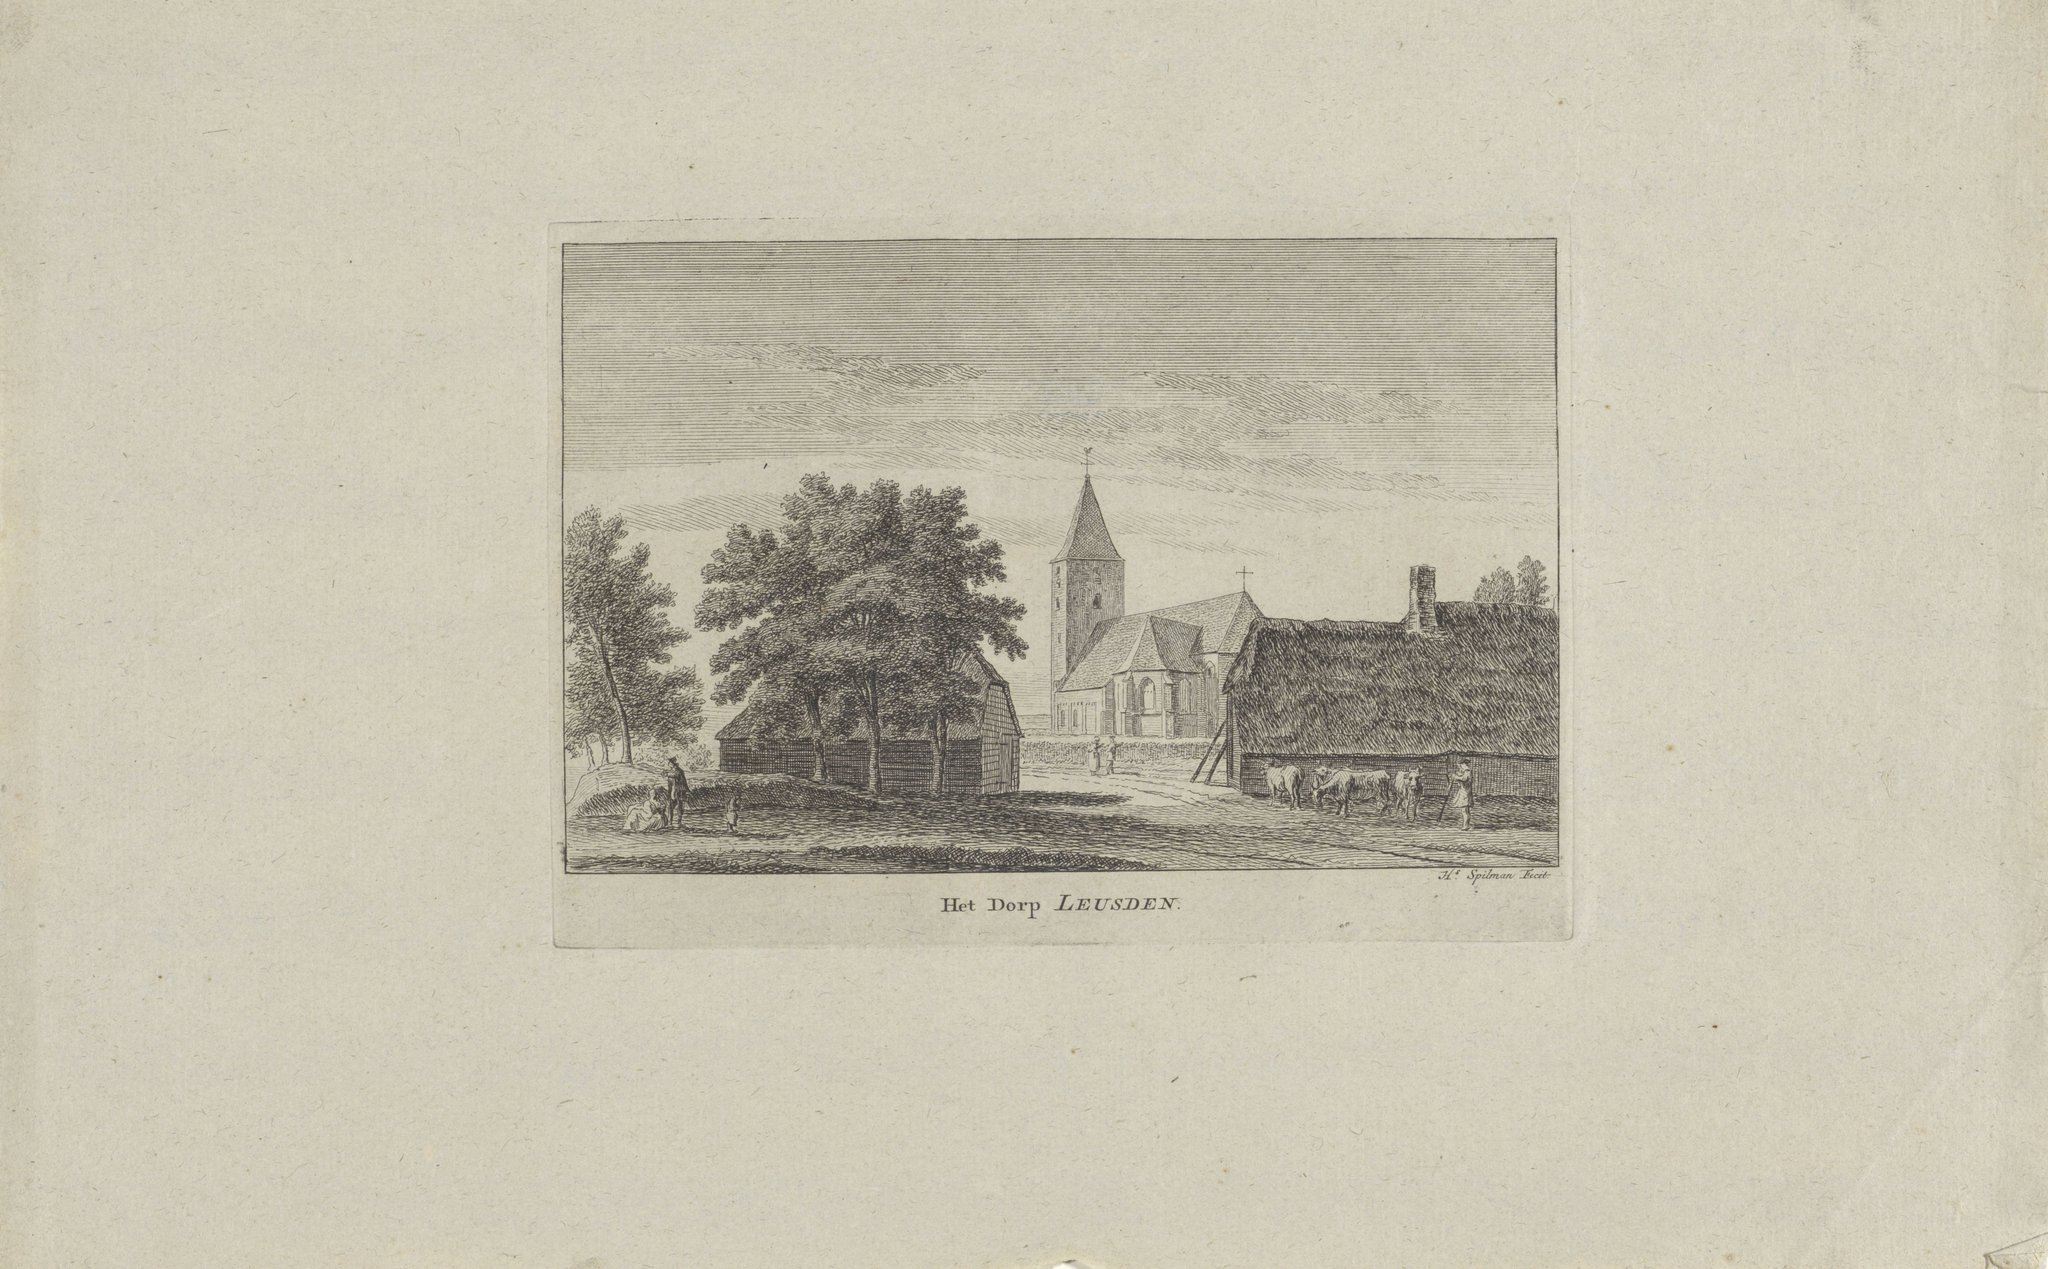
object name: print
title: Gezicht op Leusden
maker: hendrik spilman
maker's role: draughtsman, painter, print maker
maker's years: 1721-1784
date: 1742-1784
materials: paper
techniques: etching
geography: haarlem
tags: church (exterior)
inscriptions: collector's mark: Lugt 2228